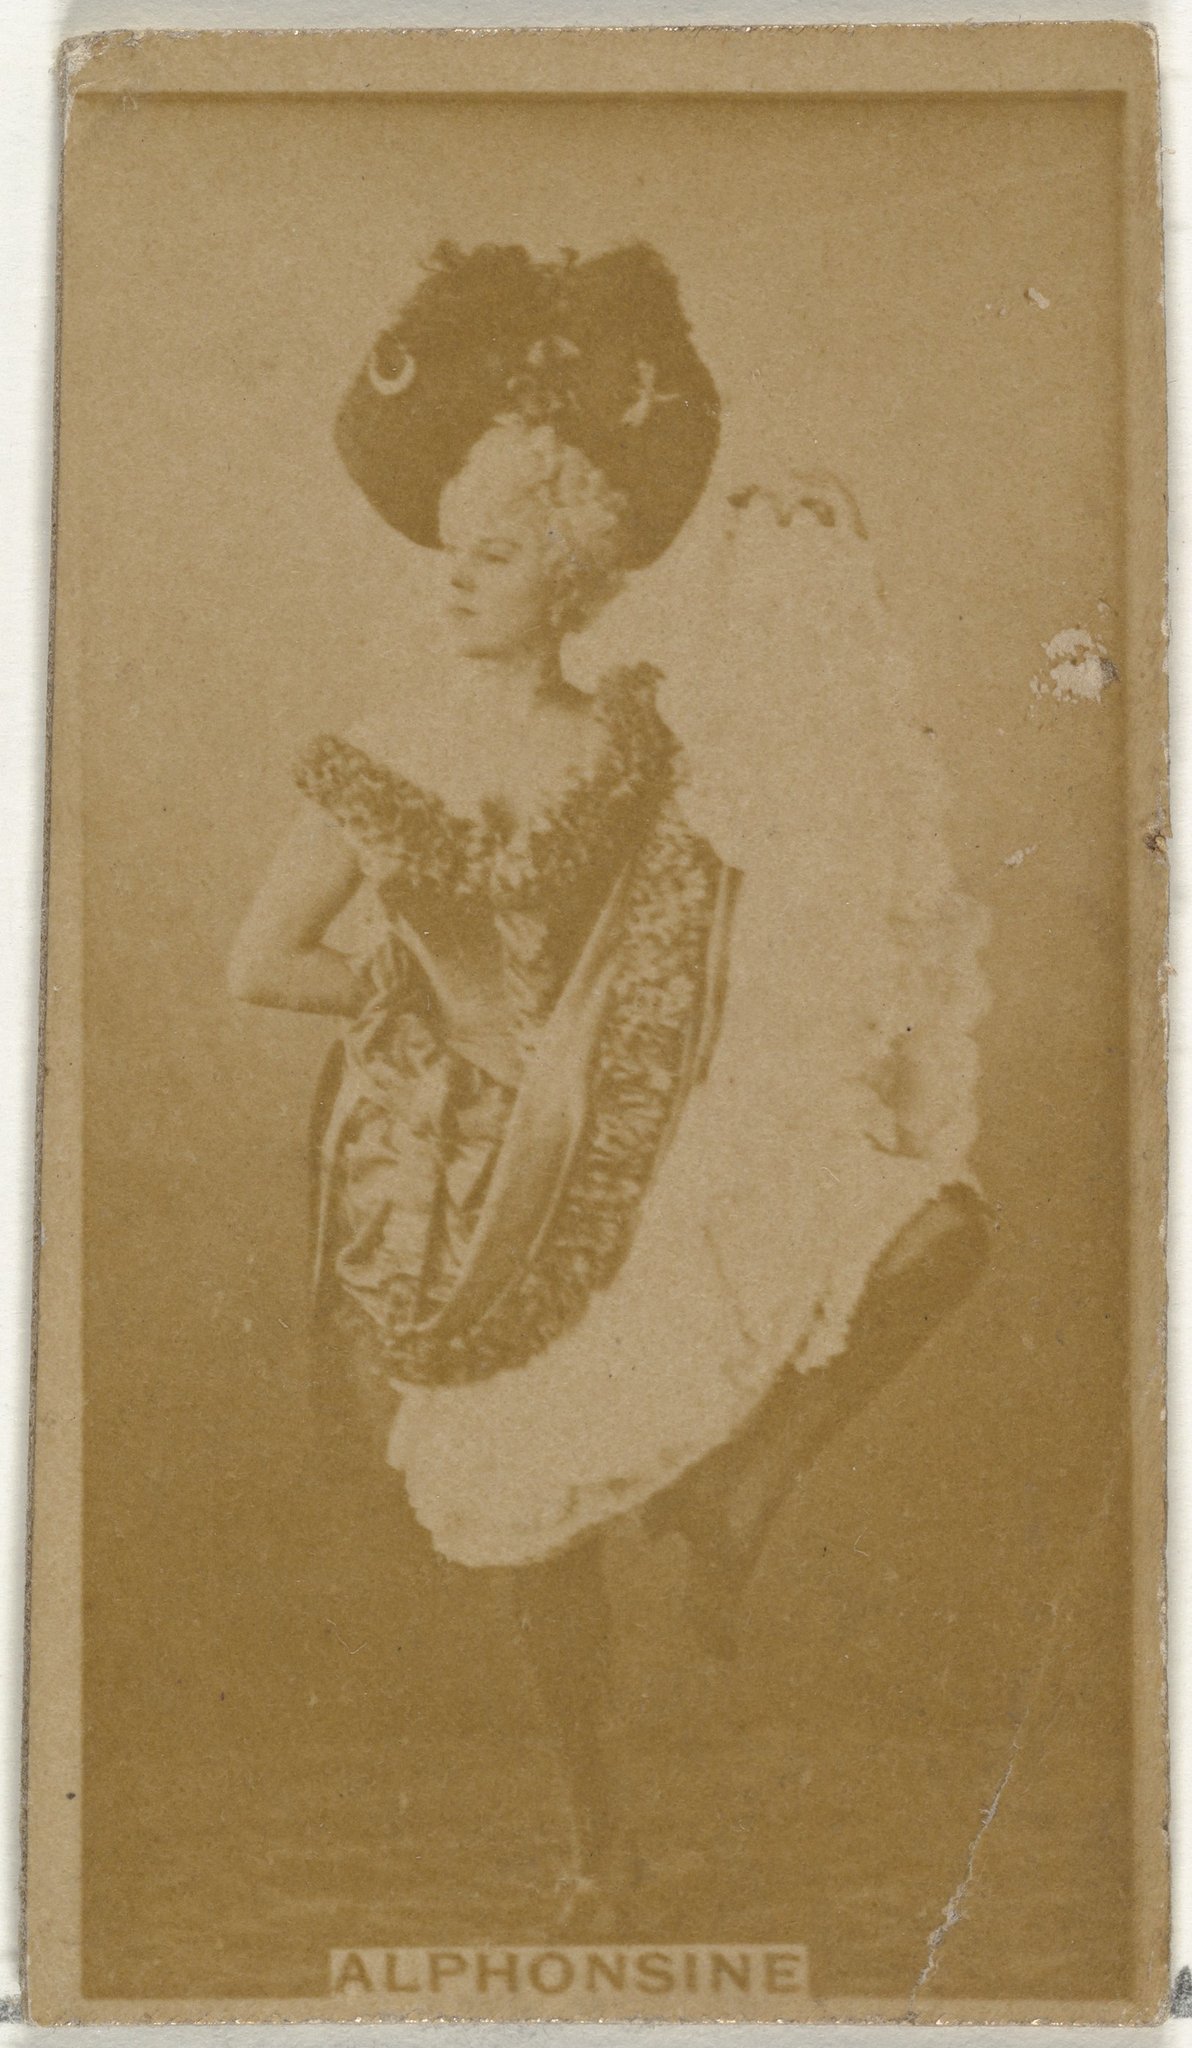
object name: photograph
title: Alphonsine, from the Actors and Actresses series (N145-8) issued by Duke Sons & Co. to promote Duke Cigarettes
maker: w. duke, sons & co.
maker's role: publisher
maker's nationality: american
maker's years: 1870-1920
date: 1891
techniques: albumen silver print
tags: women,actresses